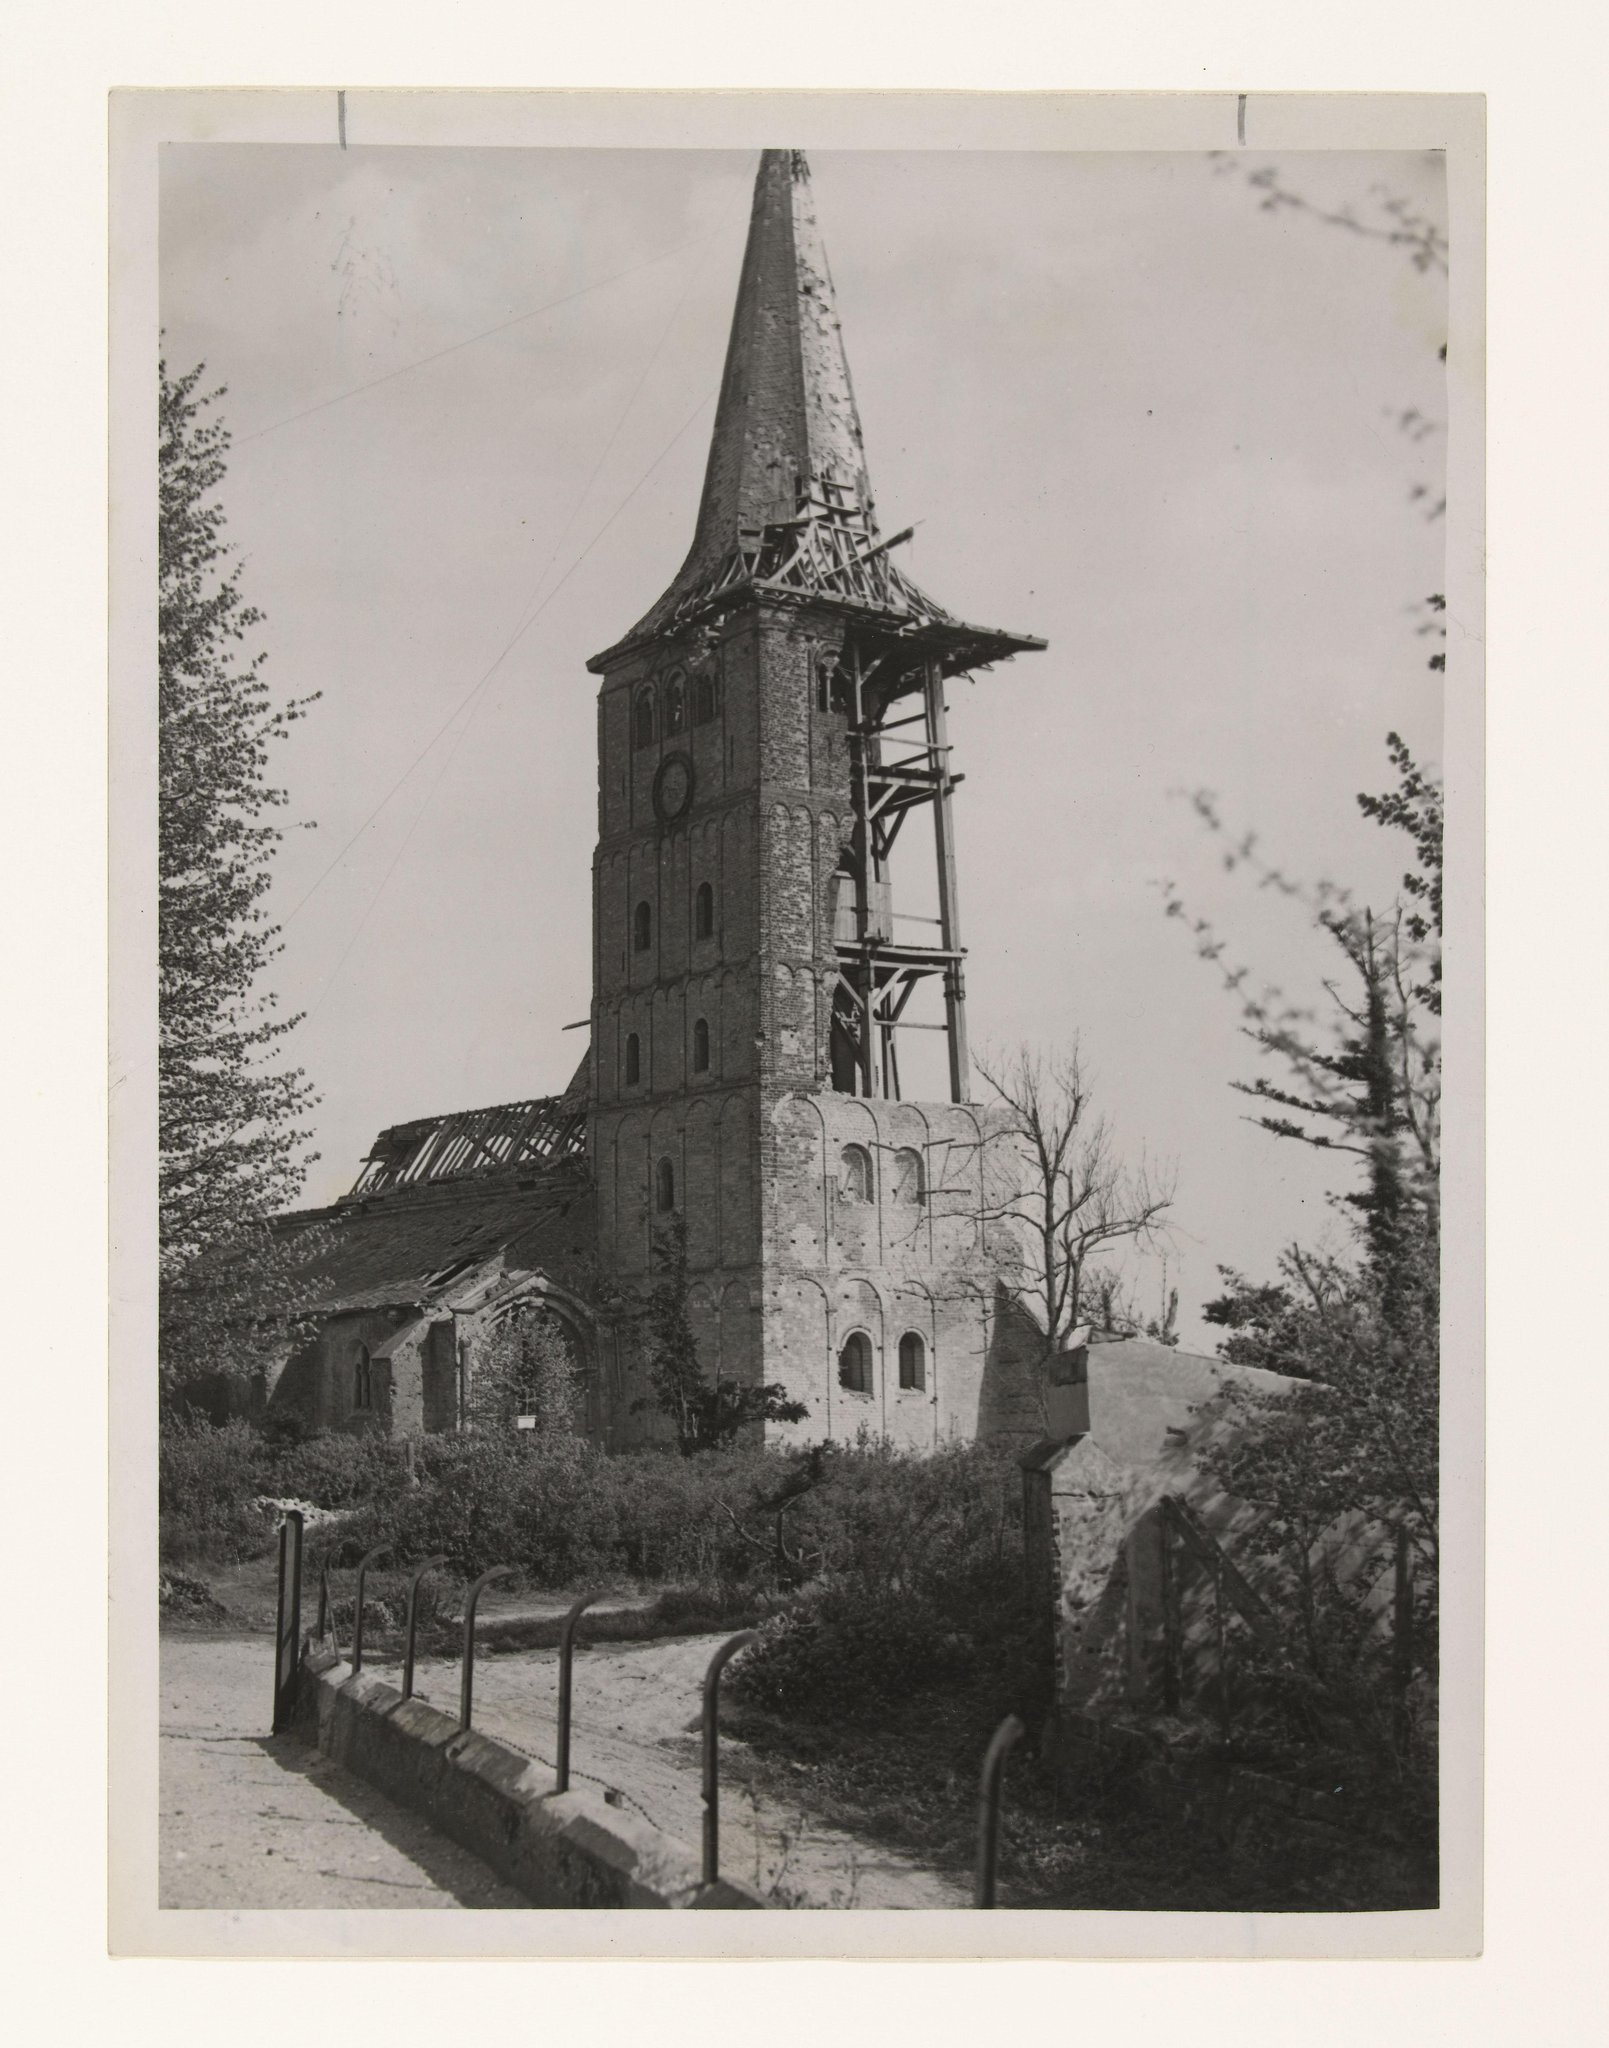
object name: documentary photograph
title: Verwoeste kerk Elten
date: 1949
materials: photographic support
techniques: photography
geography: elten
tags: elten, tweede wereldoorlog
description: De tijdens Tweede Wereldoorlog verwoeste kerk van Elten. Het dak van het schip en delen van de toren zijn volledig verwoest. Deze foto werd gepubliceerd in het artikel over de grenscorrecties om tevens een beeld te geven van het oorlogsleed van de Duitsers.